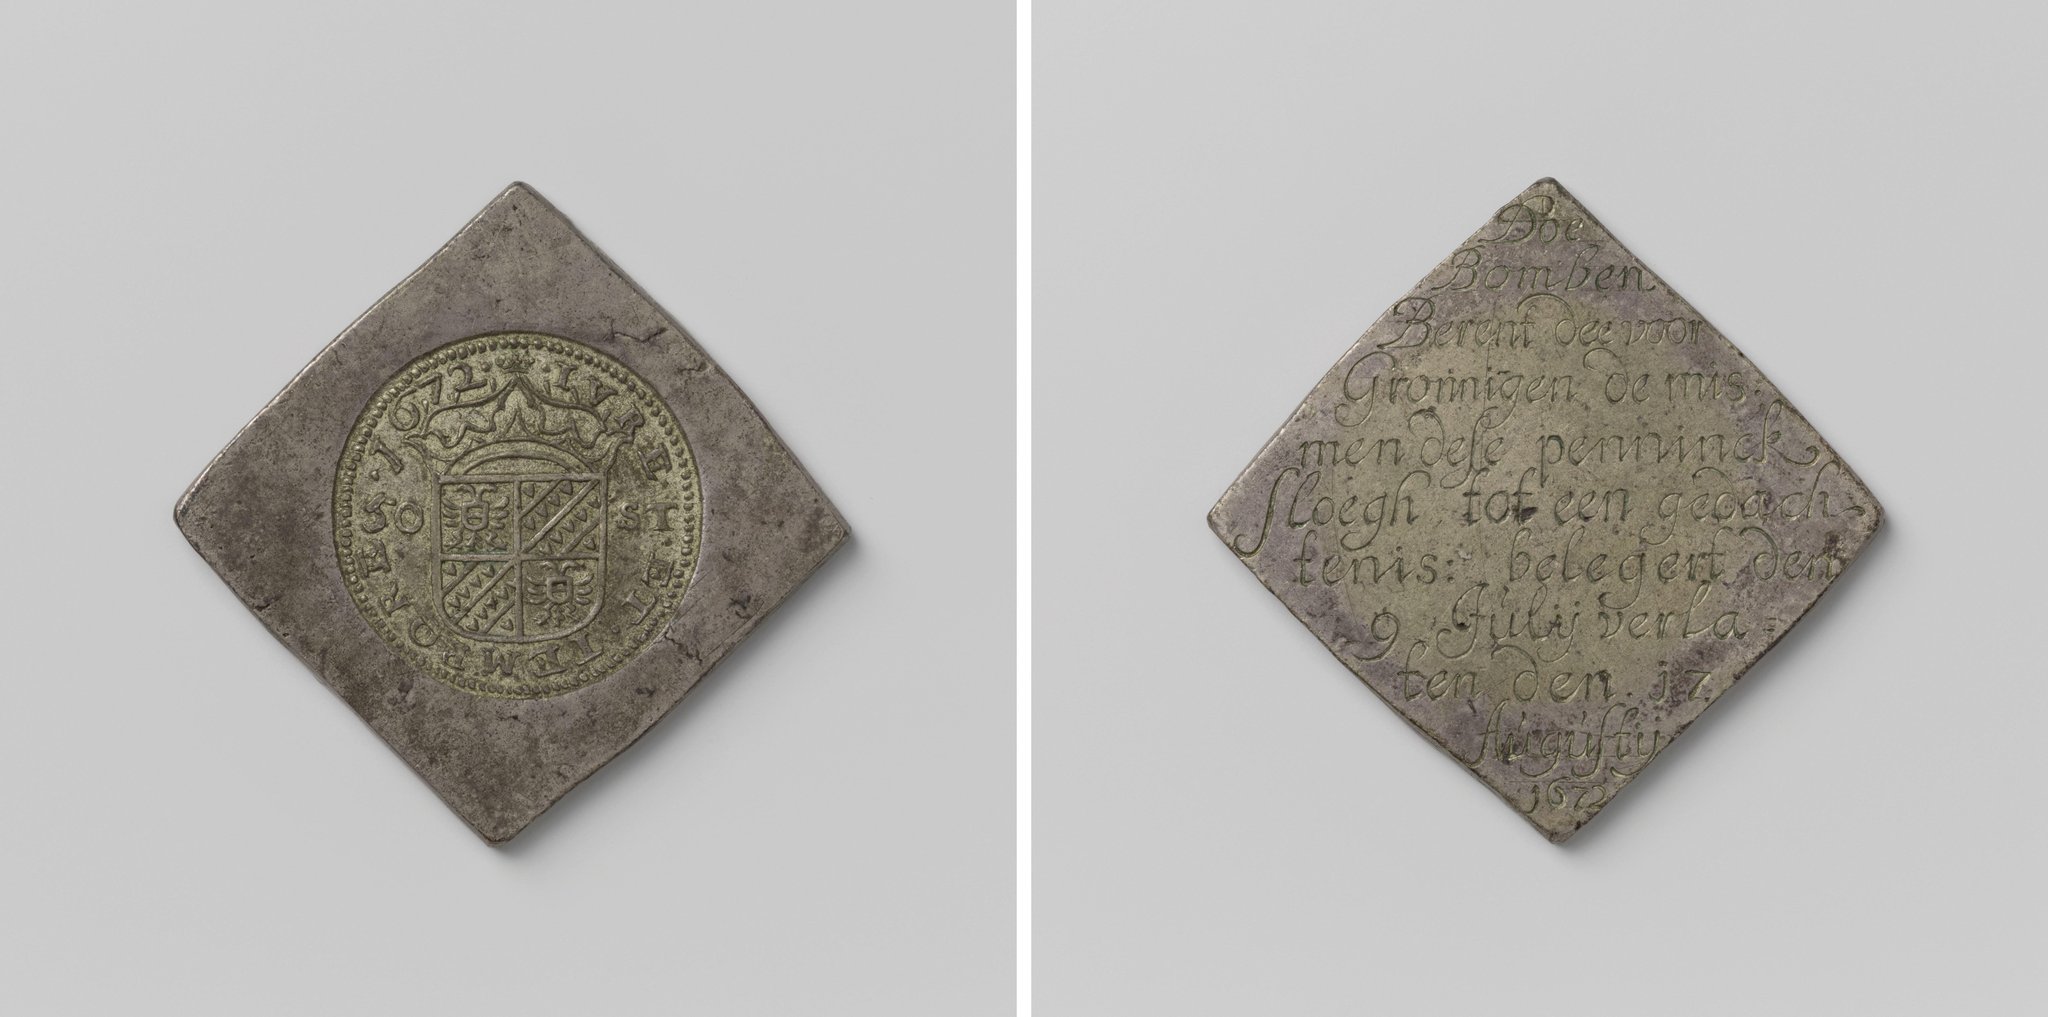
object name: siege coin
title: Daalder, noodmunt uit Groningen, geslagen tijdens het beleg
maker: Anonymous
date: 1672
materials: silver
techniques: engraving, striking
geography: groningen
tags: bisschop, christoph bernhard von galen, groningen, beleg van groningen (1672)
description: ruitvormige noodmunt uit Groningen, met afgeronde hoeken. Voorzijde: gekroond wapenschild (kleine stempel) tussen waardeaanduiding binnen omschrift. Keerzijde: opschrift "Doe Bomben Berent dee voor Gronningen de mis men dese penninck sloegh tot een gedachtenis: belegert den 9 July verlaten den 17 Augusty 1672"